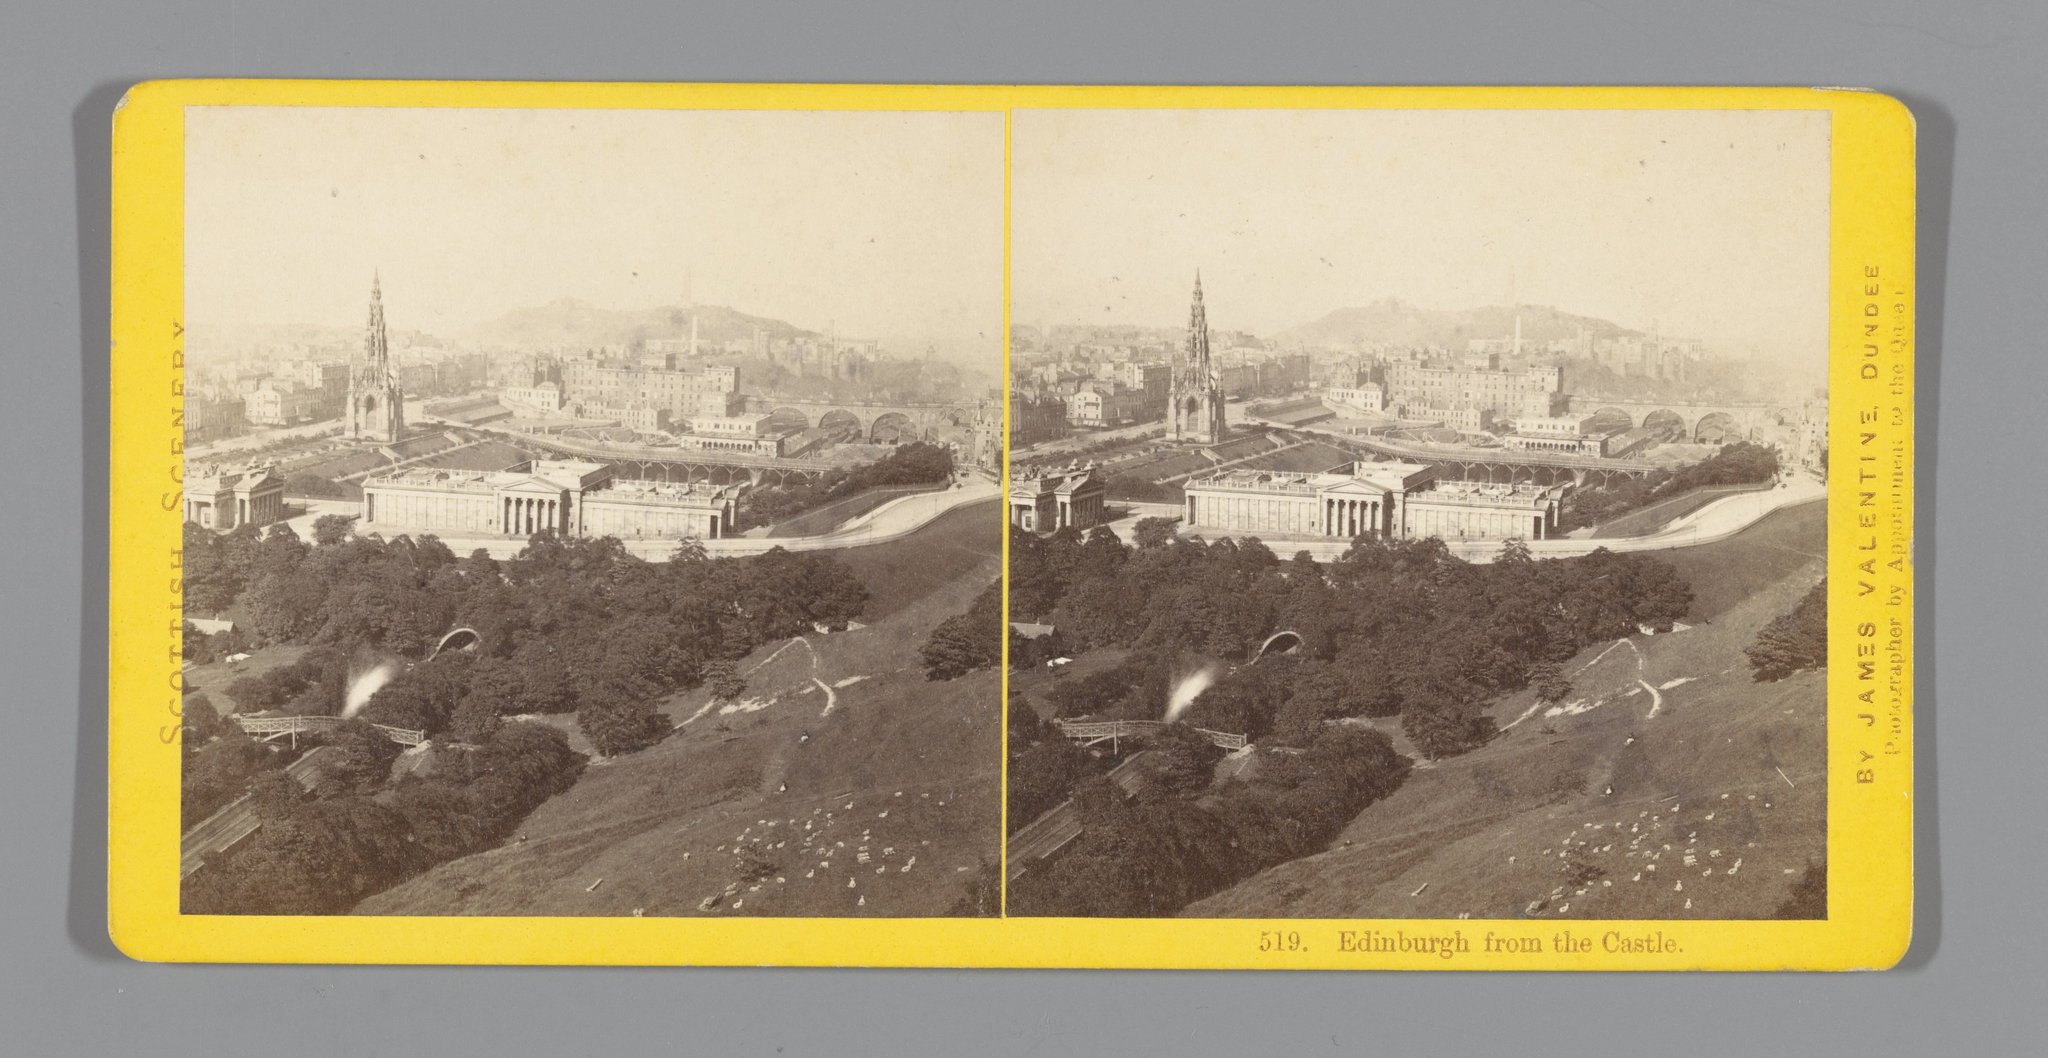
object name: stereograph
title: Edinburgh from the Castle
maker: james valentine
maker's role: fotograaf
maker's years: 1815-1880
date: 1850-1880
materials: cardboard, photographic support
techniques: albumen print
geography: edinburgh castle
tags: city-view in general; 'veduta'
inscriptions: inscription: ‘Scottish Scenery’, name: ‘By James Valentine, Dundee Photographer by Appointment to the Queen’, number: ‘519.’